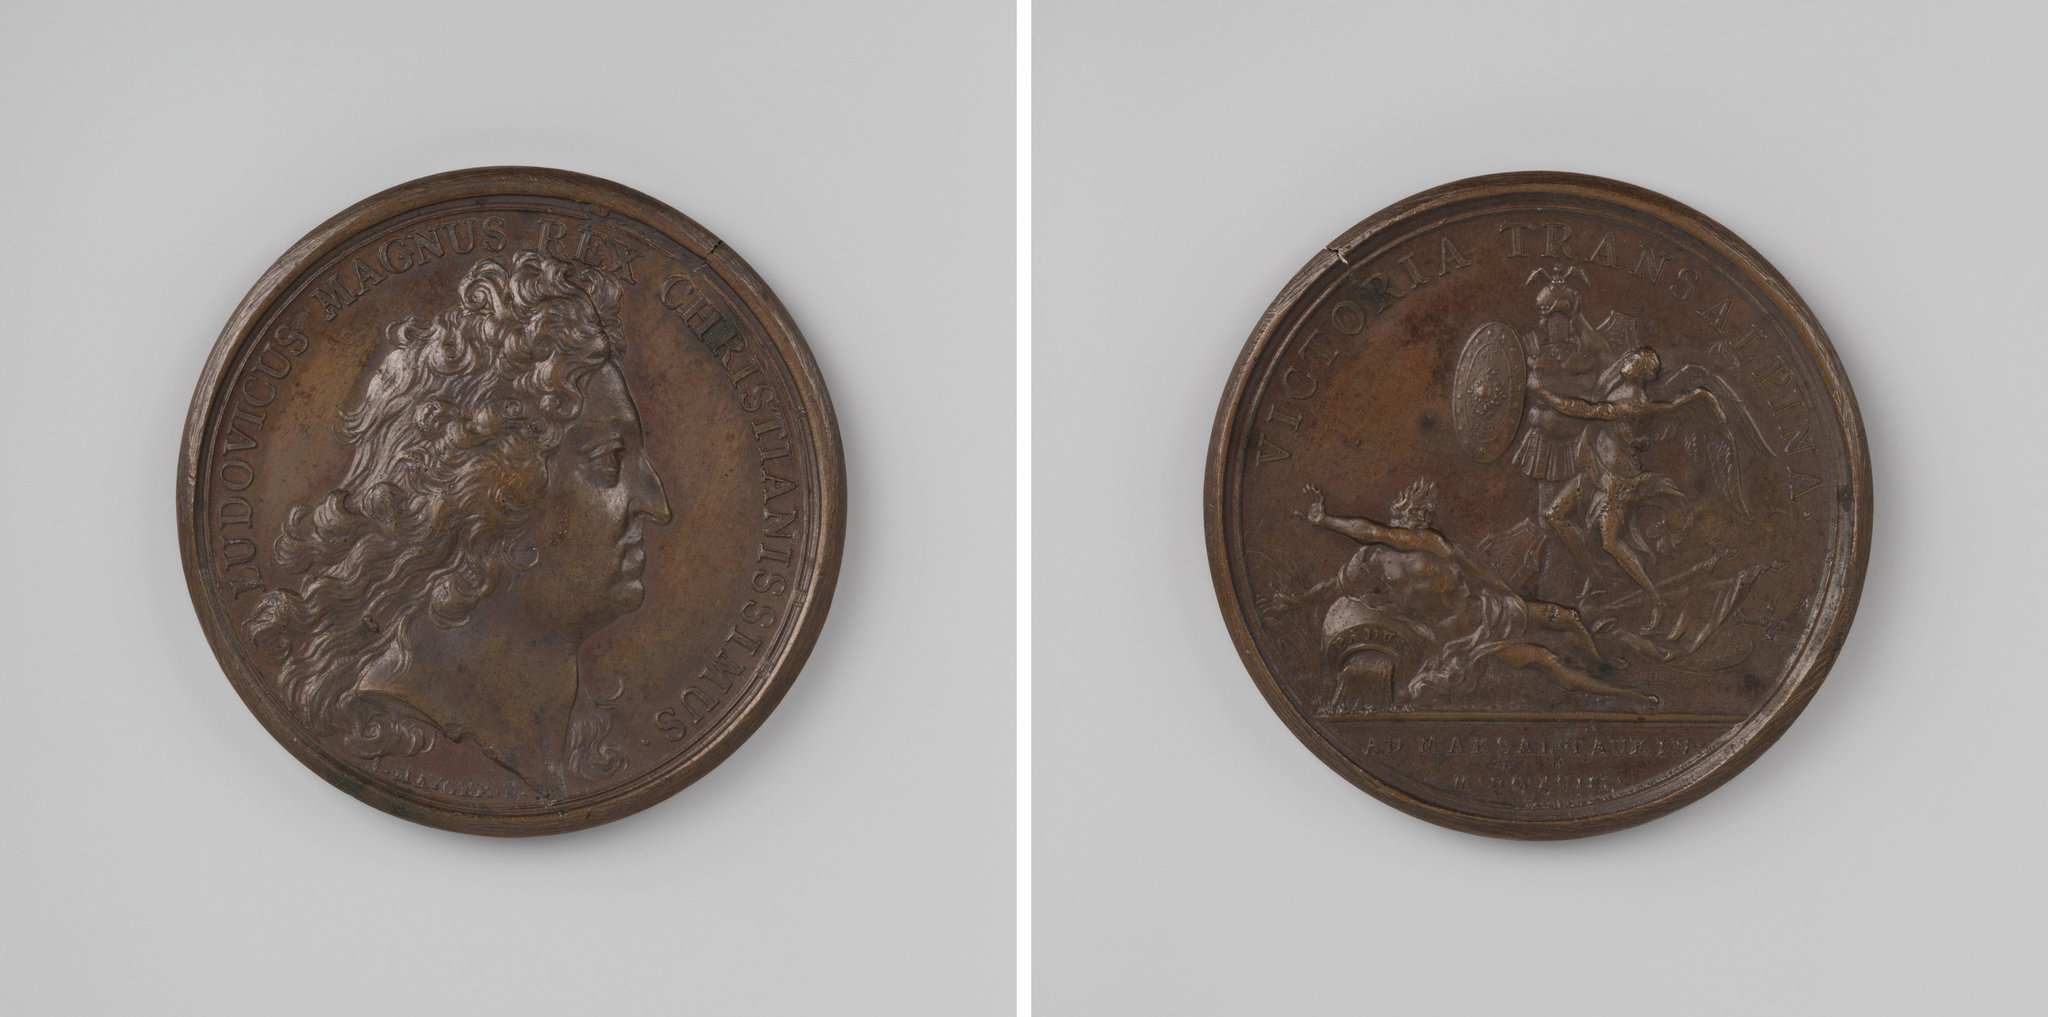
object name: history medal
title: Overwinning van de Fransen bij Marsaglia aan de Po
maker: jean mauger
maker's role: medailleur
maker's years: 1648-1722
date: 1699-1703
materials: bronze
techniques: striking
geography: paris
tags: lodewijk xiv (koning van frankrijk)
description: Bronzen penning. Voorzijde: borststuk man binnen omschrift. Keerzijde: Overwinning richt zegeteken op naast verschrikte riviergod binnen omschrift; afsnede: opschrift